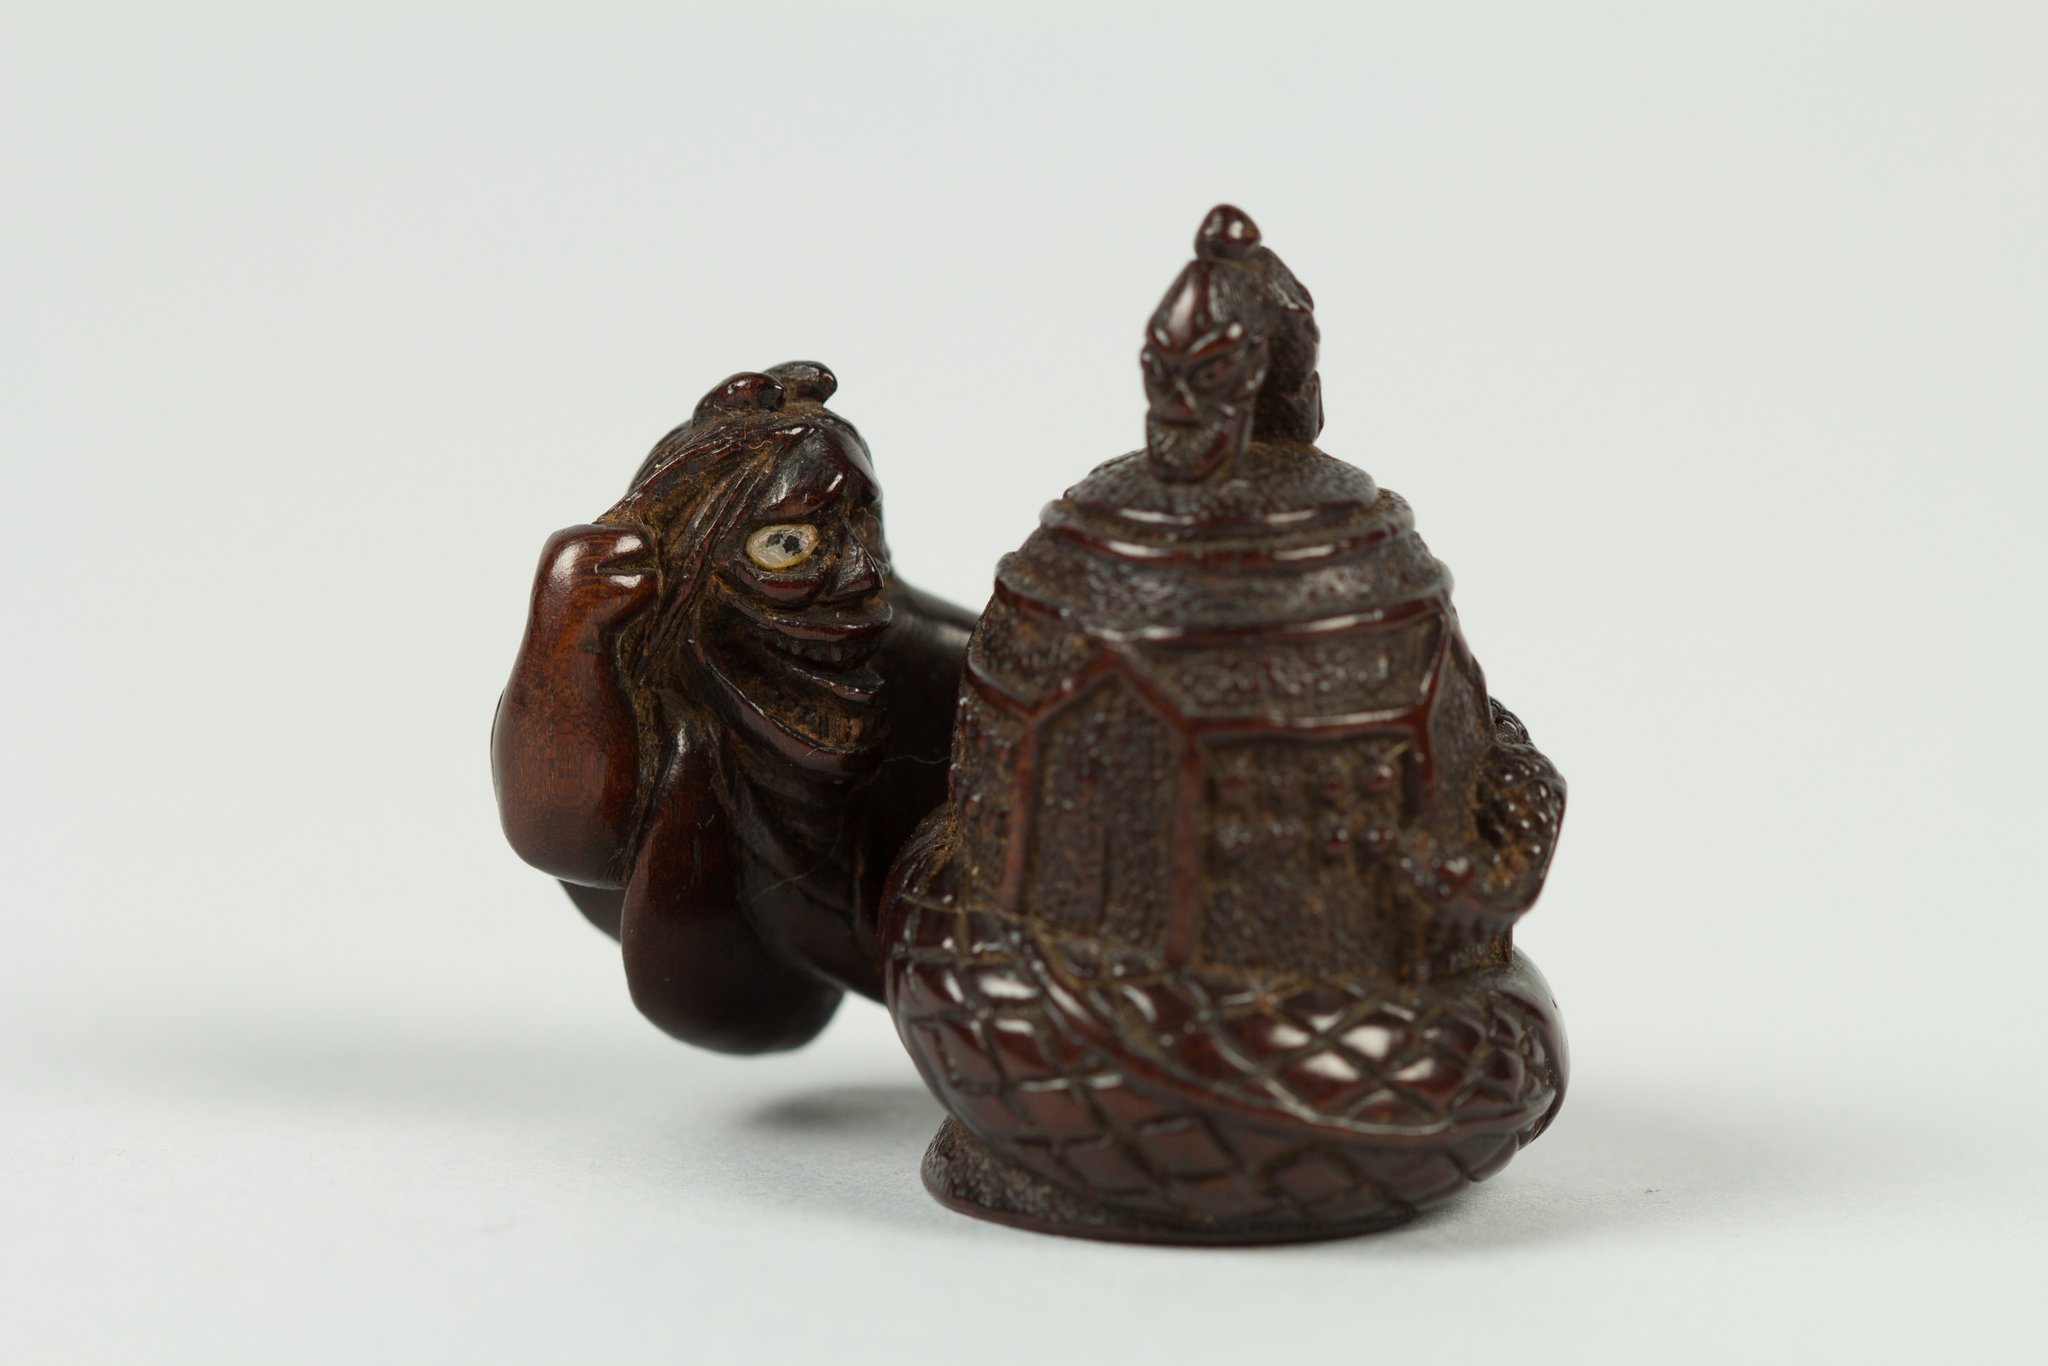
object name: netsuke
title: Netsuke of Kiyohime with the Bell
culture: japanese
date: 1801-1900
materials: wood